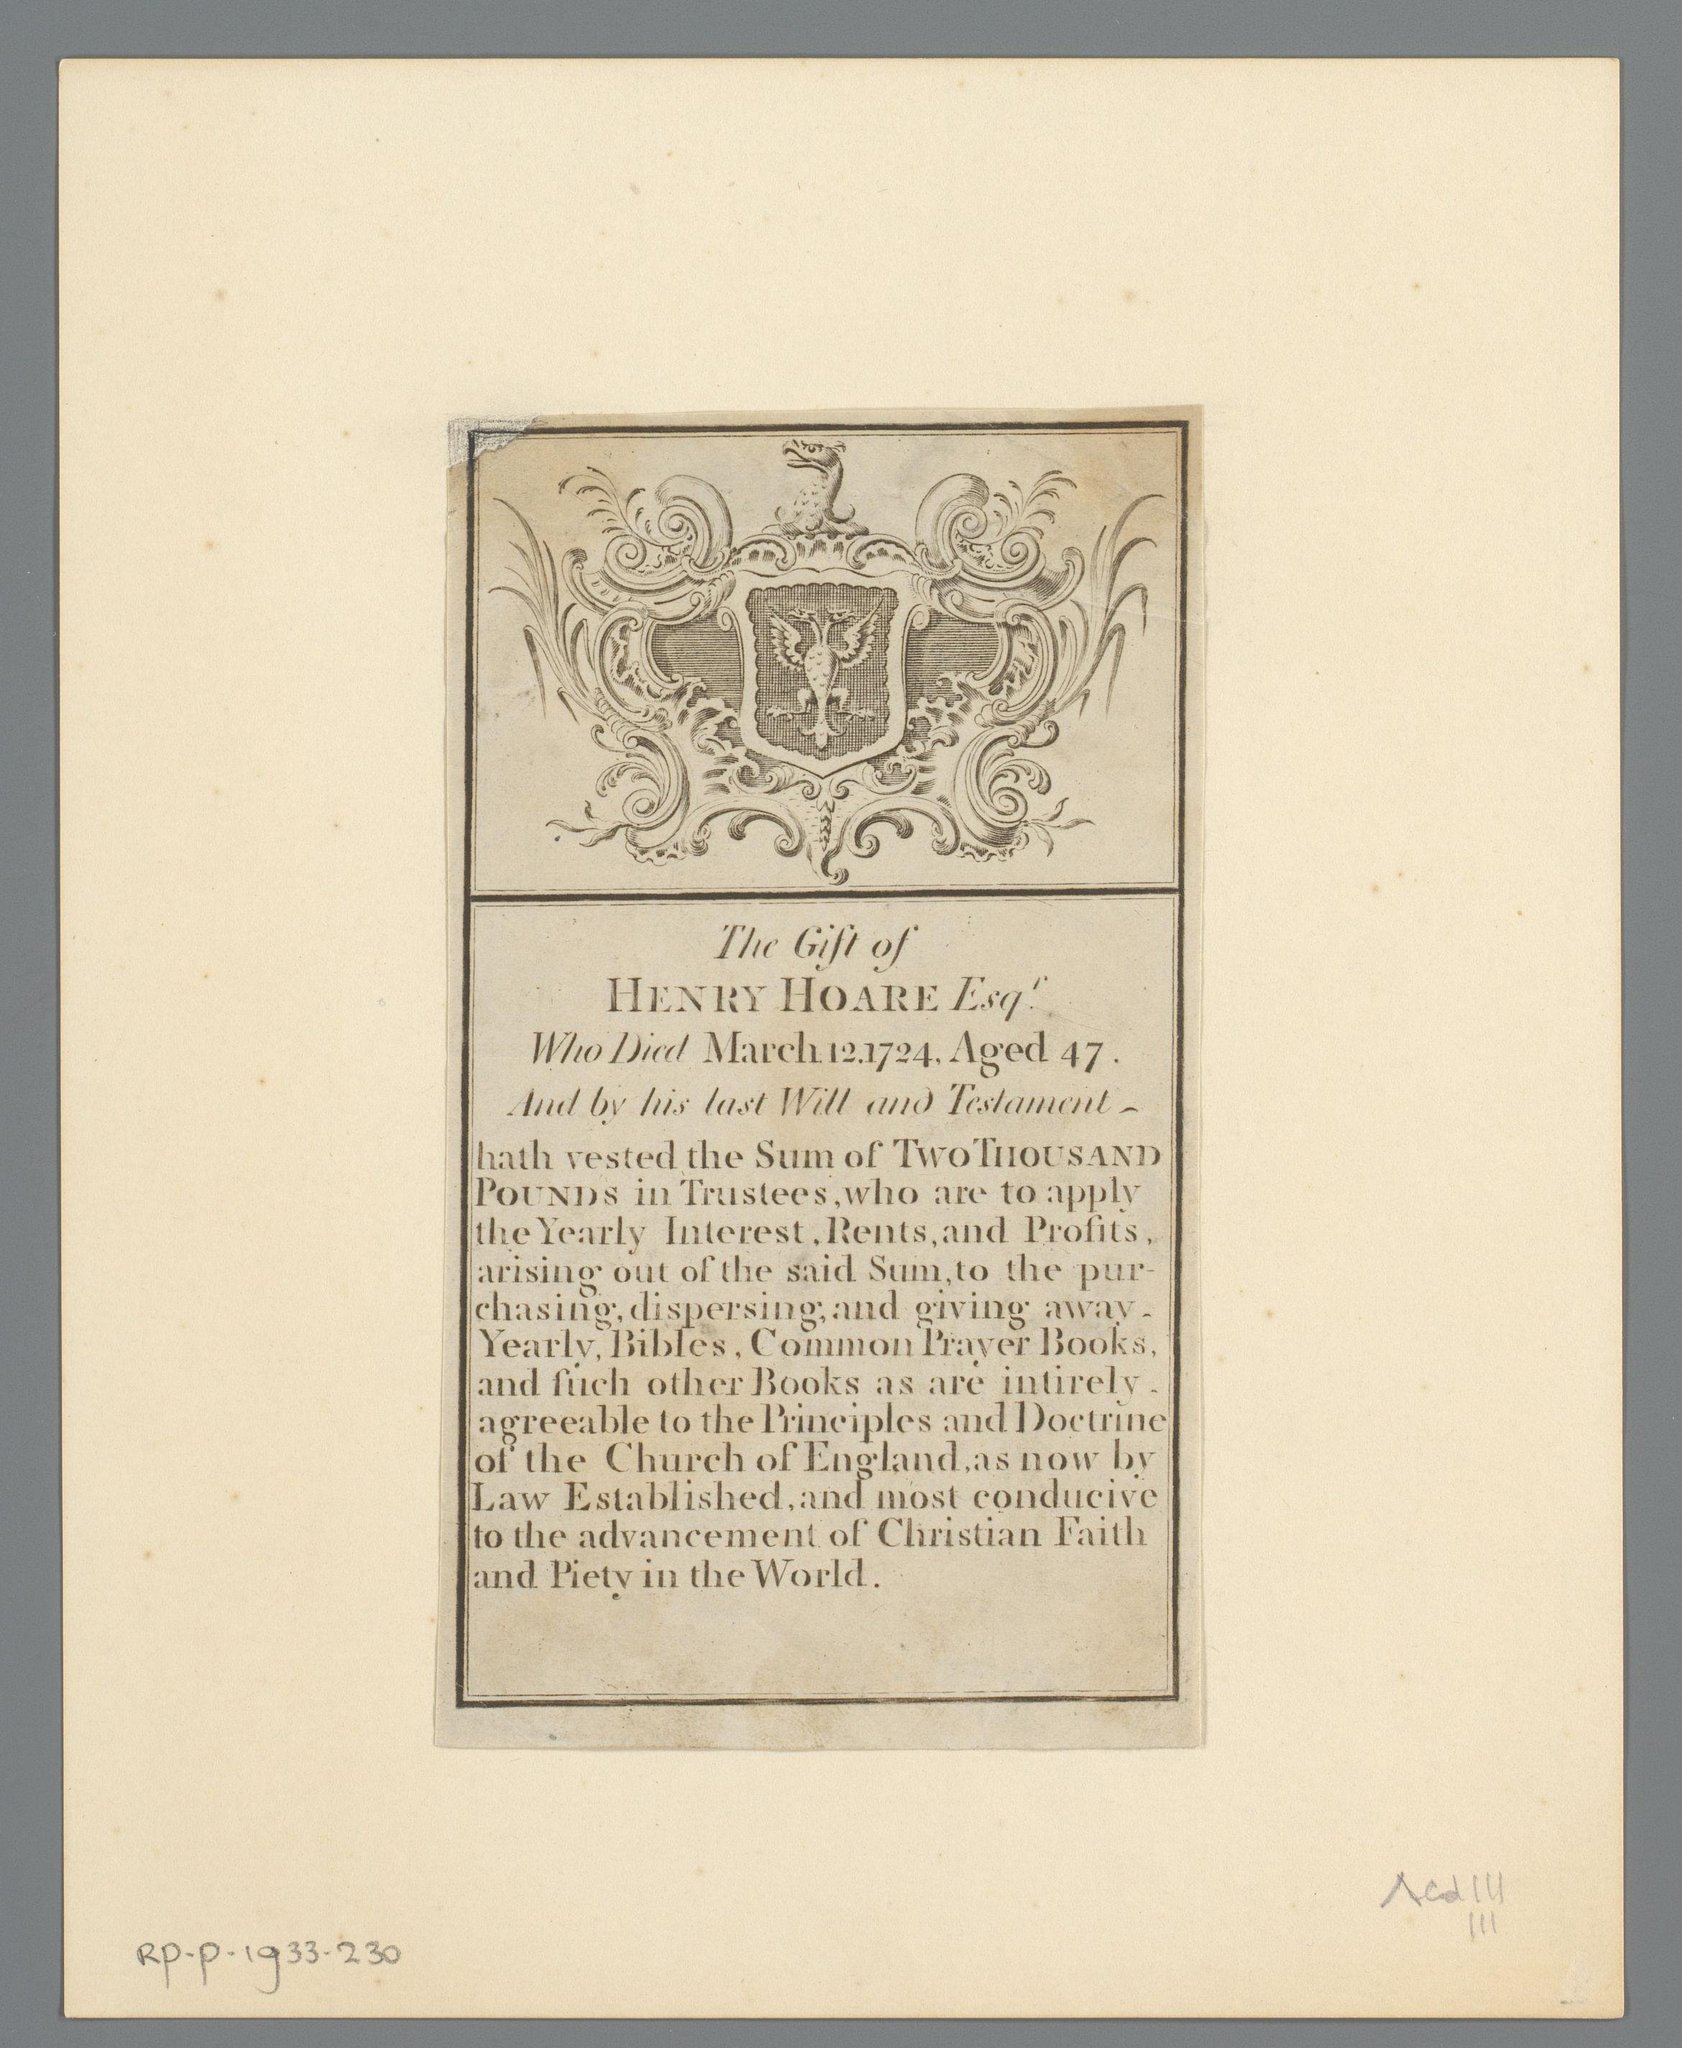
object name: print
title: Herdenkingsprent voor Henry Hoare met details over zijn nalatenschap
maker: Anonymous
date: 1724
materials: paper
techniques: engraving, etching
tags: inheritance, armorial bearing, heraldry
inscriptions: collector's mark: Lugt 2760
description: Onder het wapen van Henry Hoare I een aankondiging van diens investering uit nalatenschap van tweeduizend pond in een fonds. De opbrengst uit dit fonds was bedoeld voor de aankoop van Bijbels en gebedenboeken voor de Church of England.